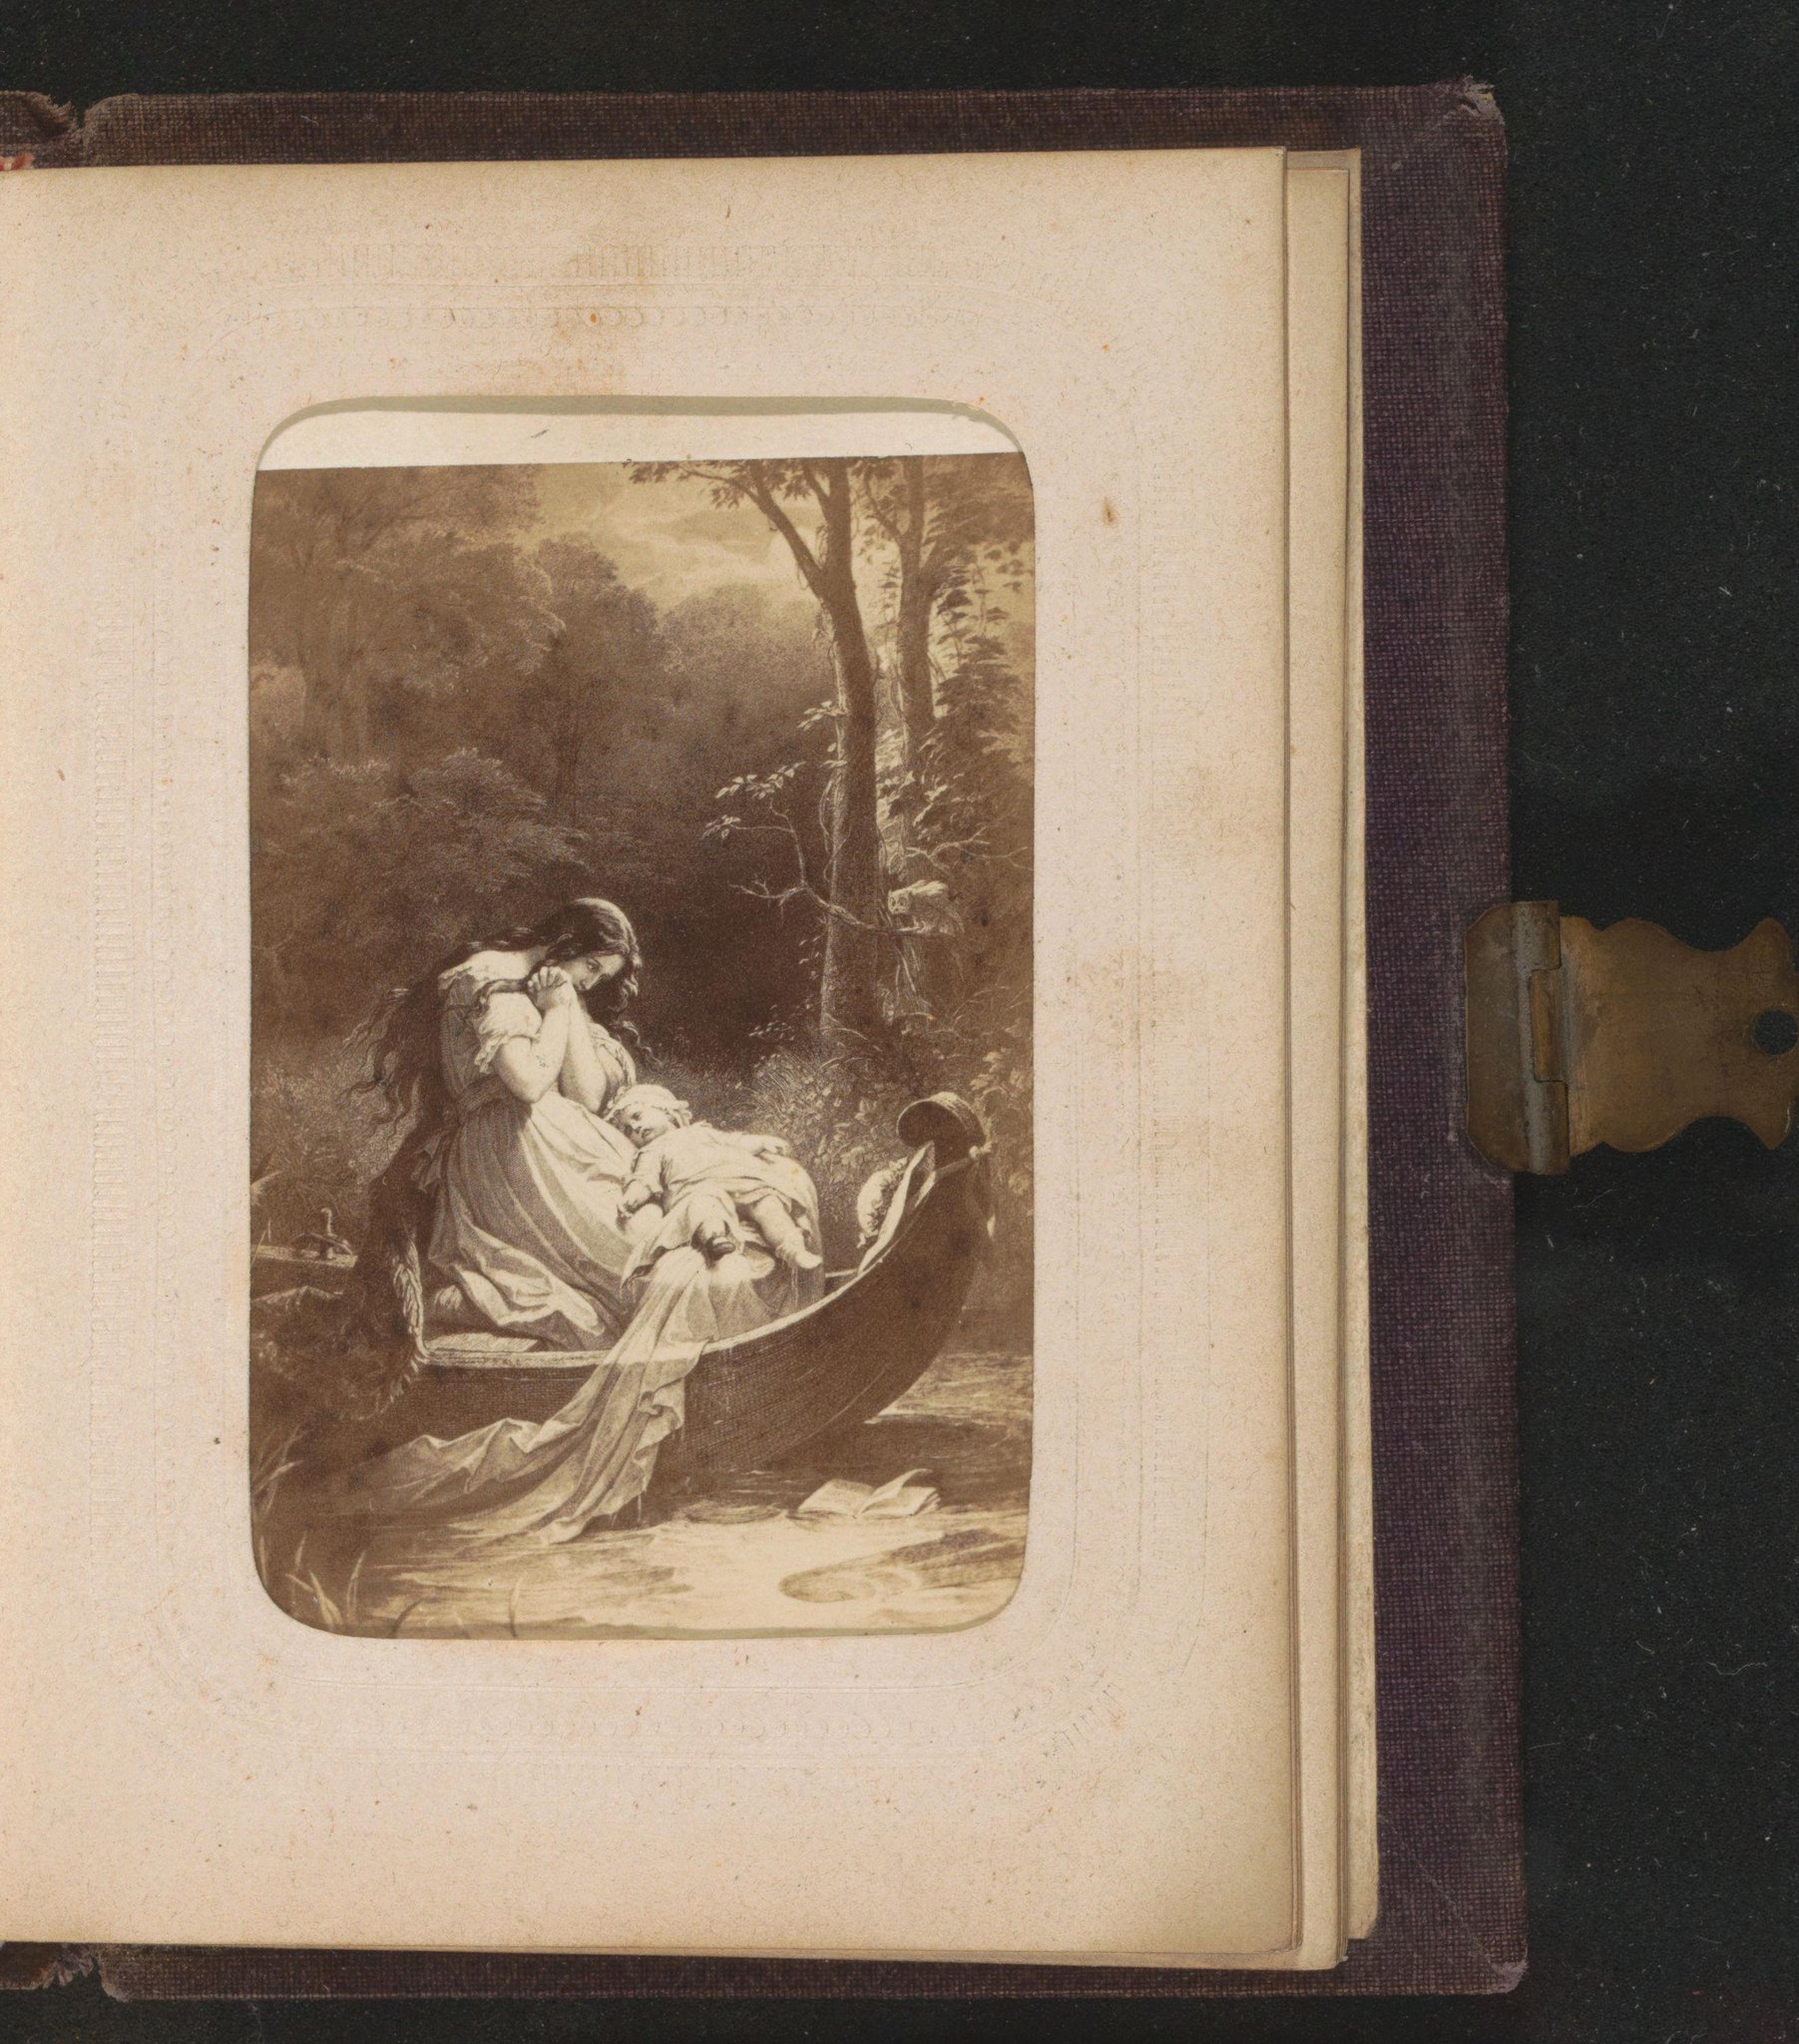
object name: photograph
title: Ottilie (Wahlverwandtschaften) W. von Kaulbach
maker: andries jager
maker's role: publisher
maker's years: 1825-1905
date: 1860-1890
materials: cardboard, paper, photographic support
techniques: albumen print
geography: amsterdam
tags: adolescent, young woman, maiden, mother and baby or young child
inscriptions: address: ‘Water 110 Amsterdam’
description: Onderdeel van Fotoalbum met 16 cartes-de-visite van vrouwenfiguren uit het werk van J.W. von Goethe.